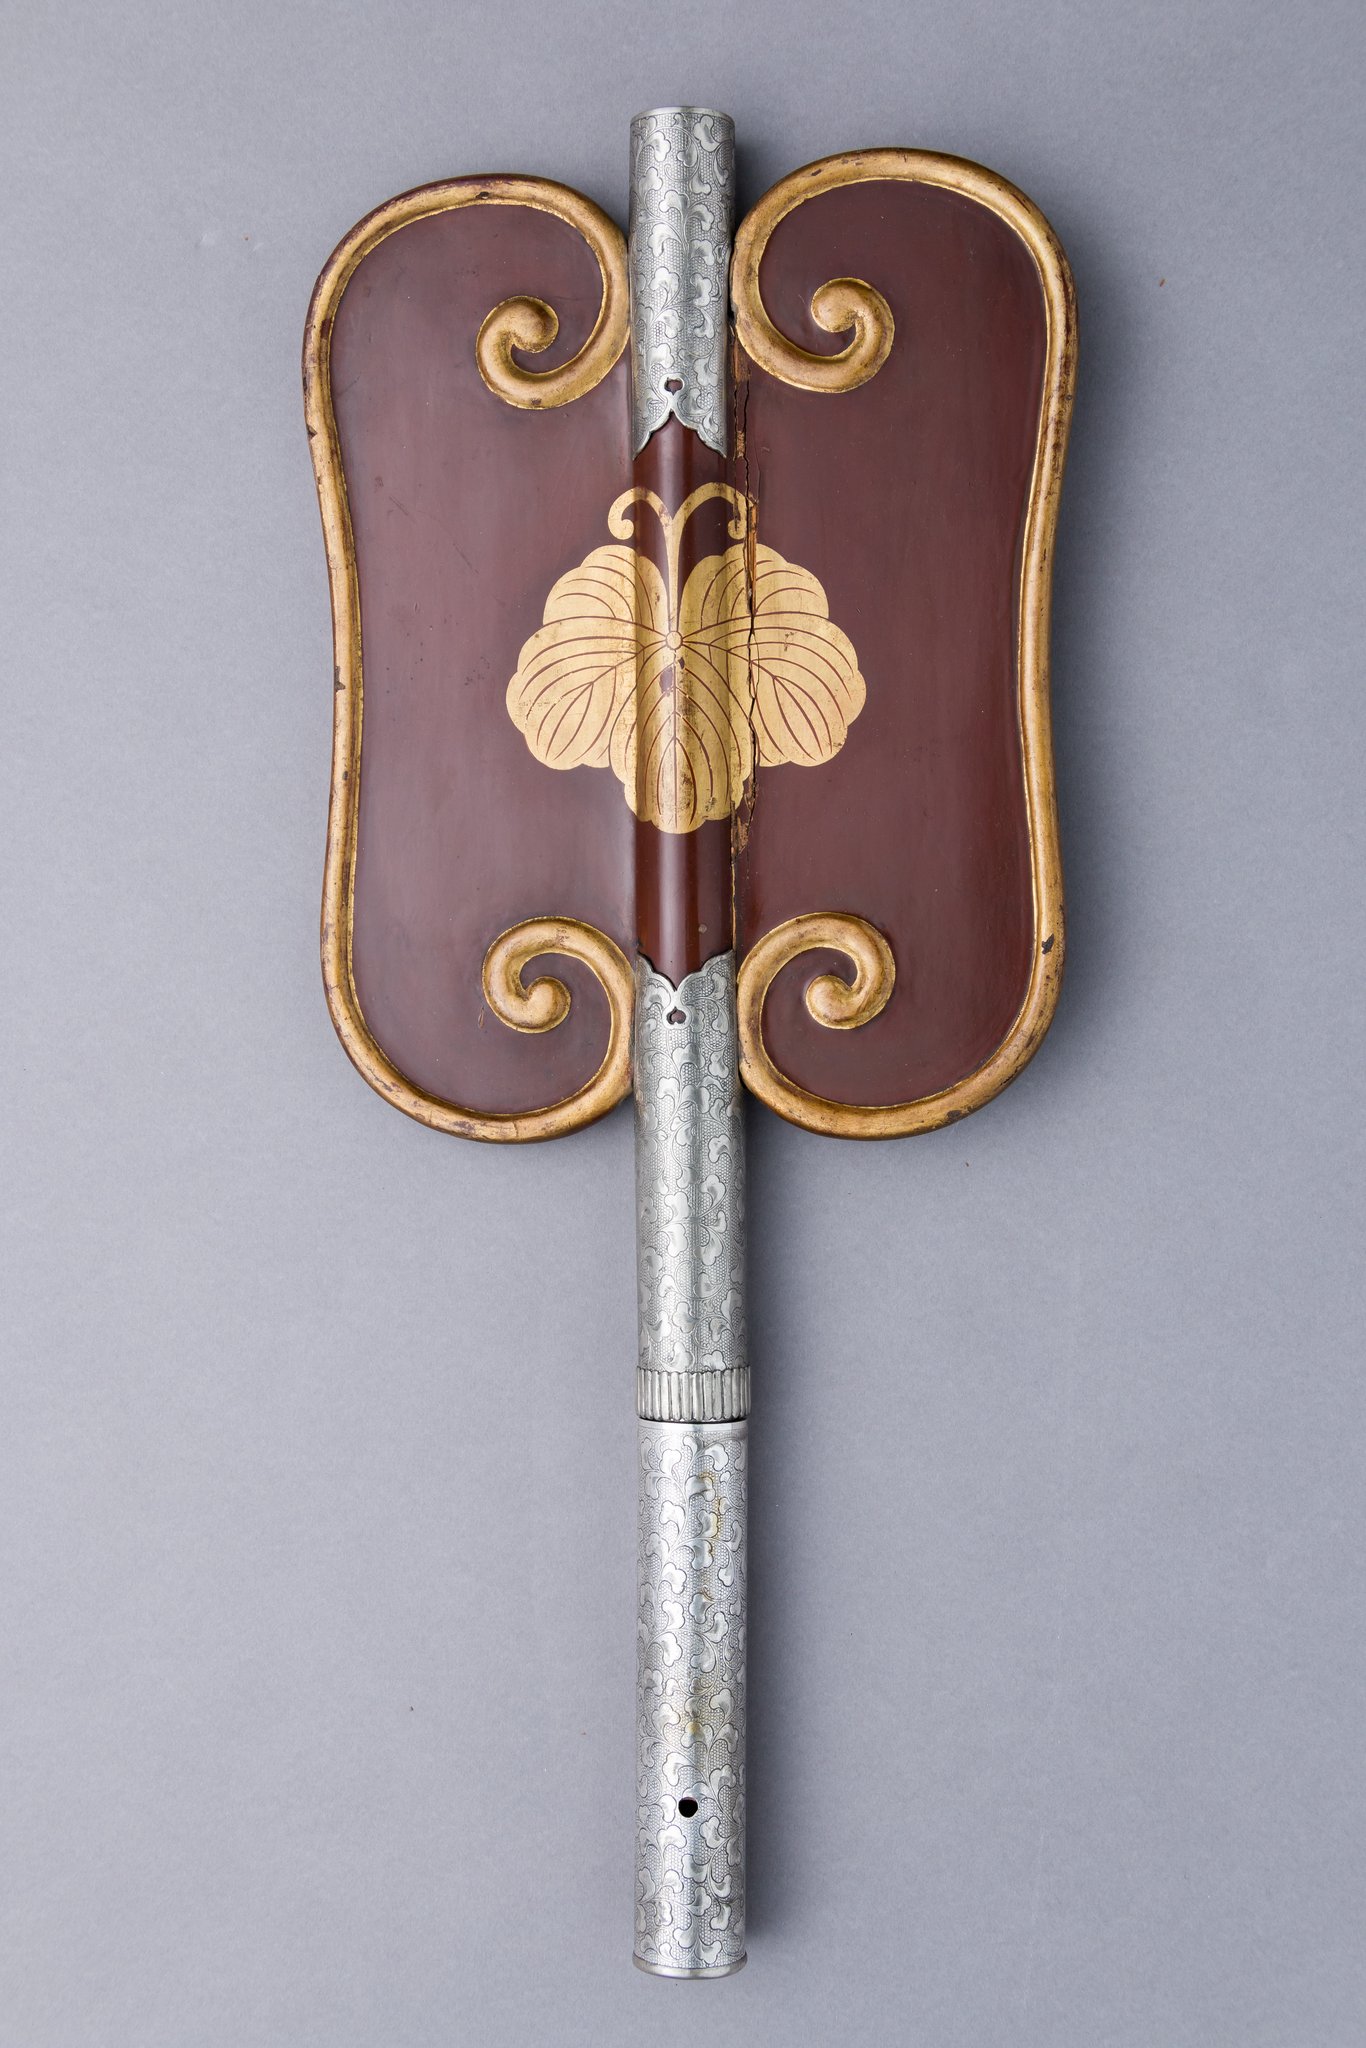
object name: war fan i gunbai i with concealed spear blade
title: War Fan (Gunbai) with Concealed Spear Blade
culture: japanese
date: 1701-1800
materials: lacquer, silk, silver, steel, wood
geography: japan